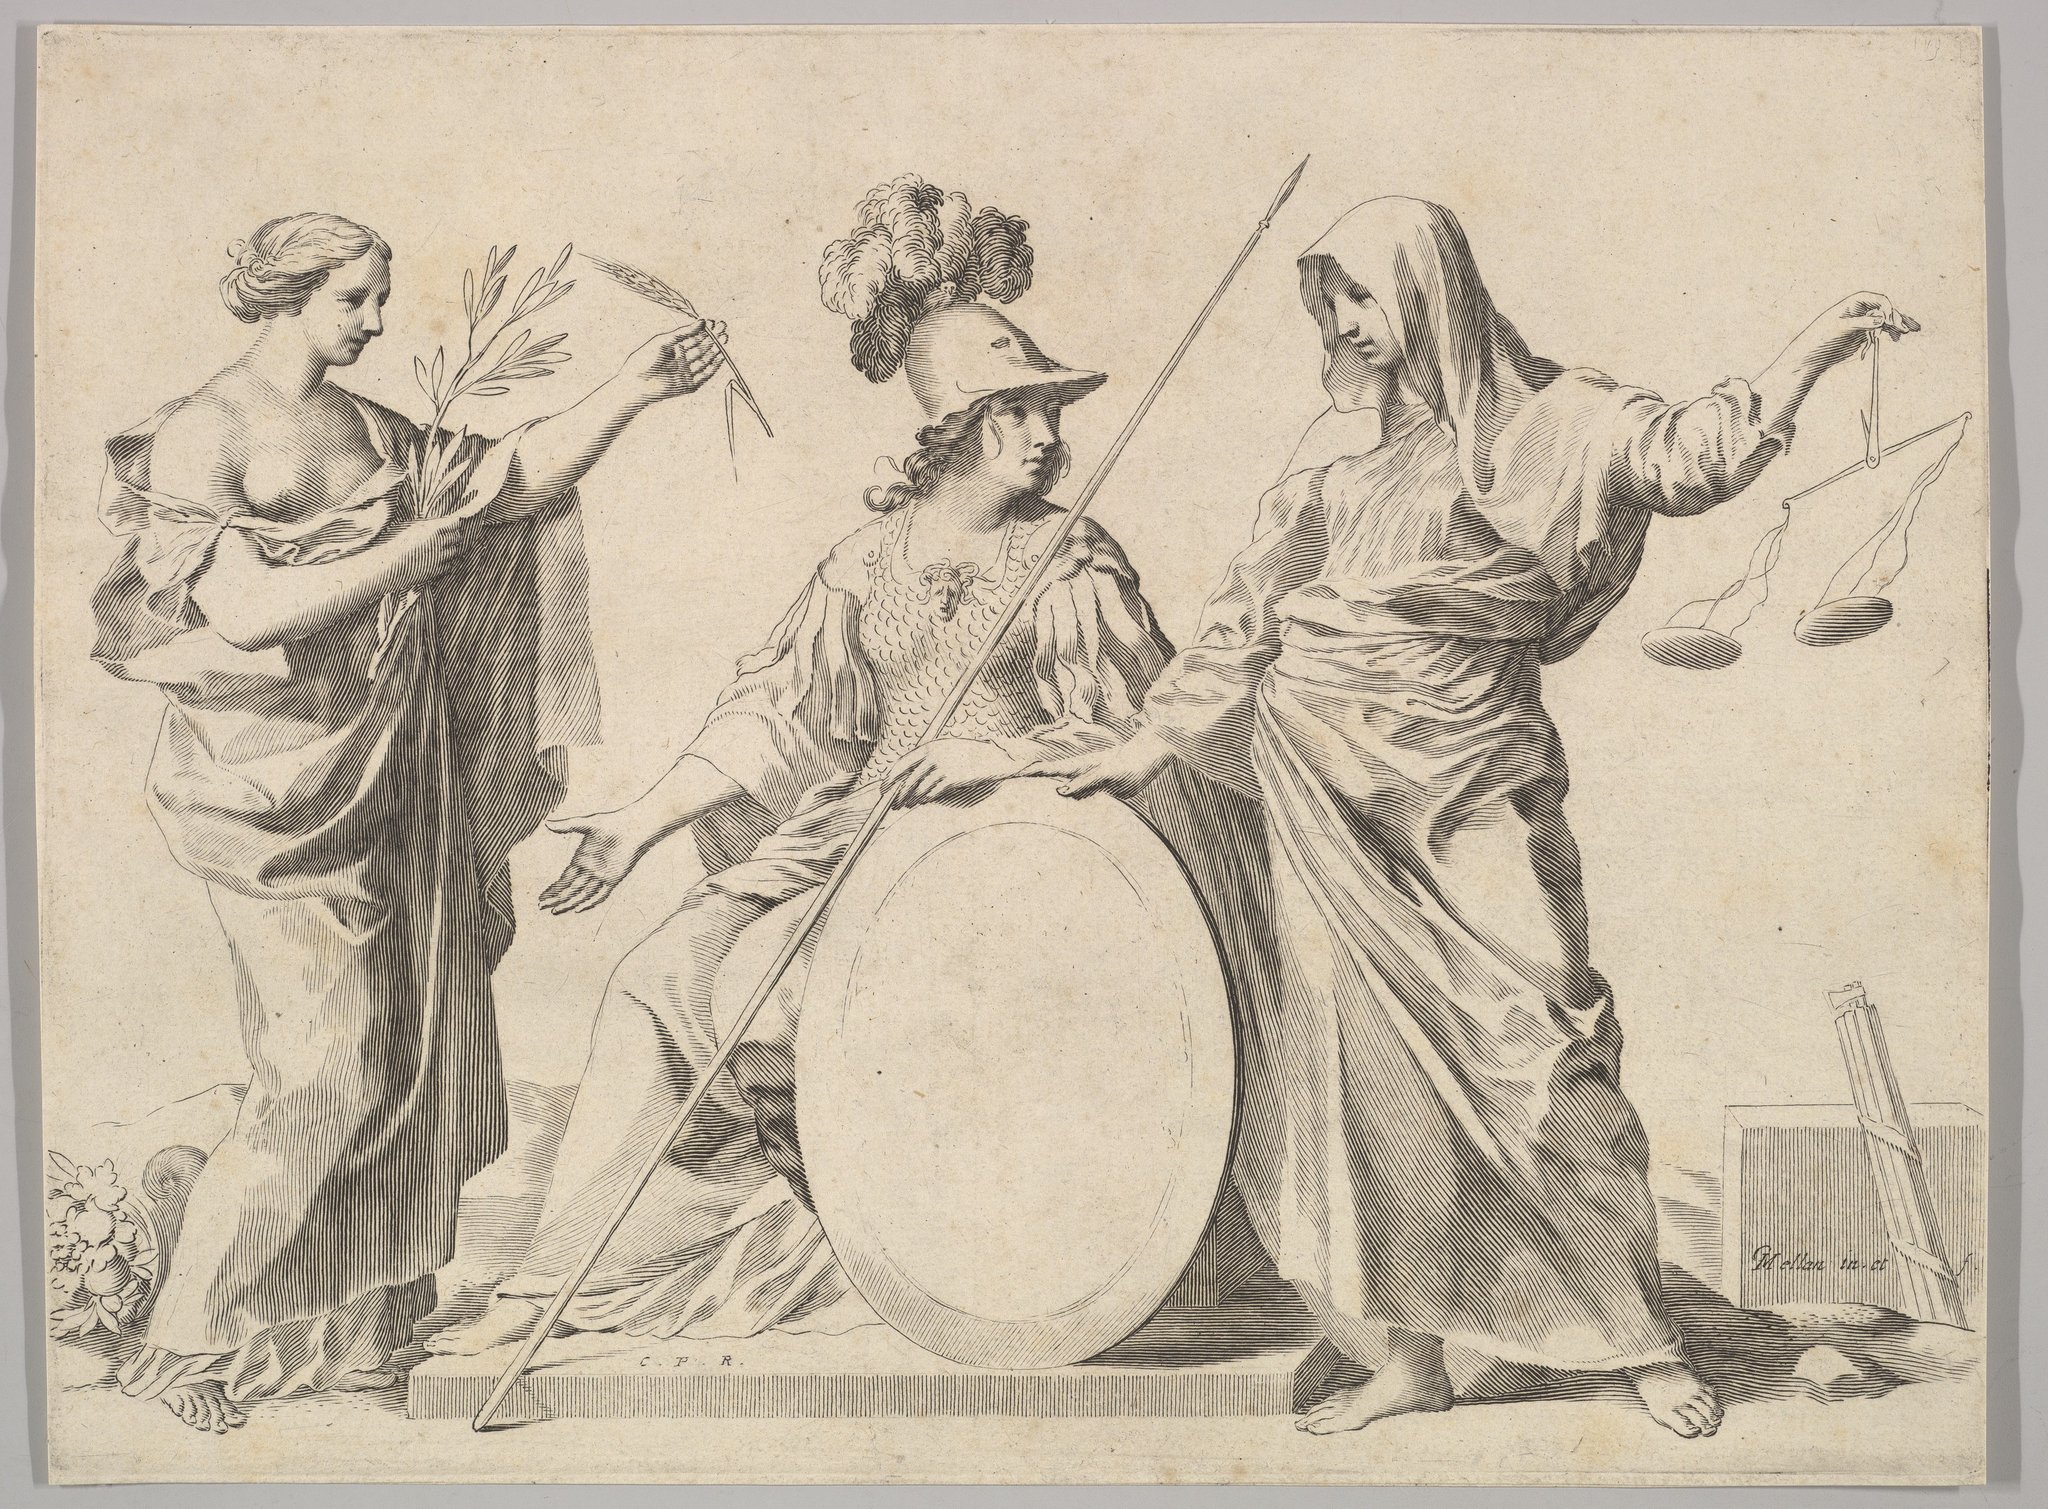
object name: print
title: Minerva Flanked by Peace and Justice (Armoiries de Gallard et de Mesmes)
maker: claude mellan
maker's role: artist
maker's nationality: french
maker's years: 1598-1688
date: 1600-1688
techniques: engraving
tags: minerva,goddess,scales